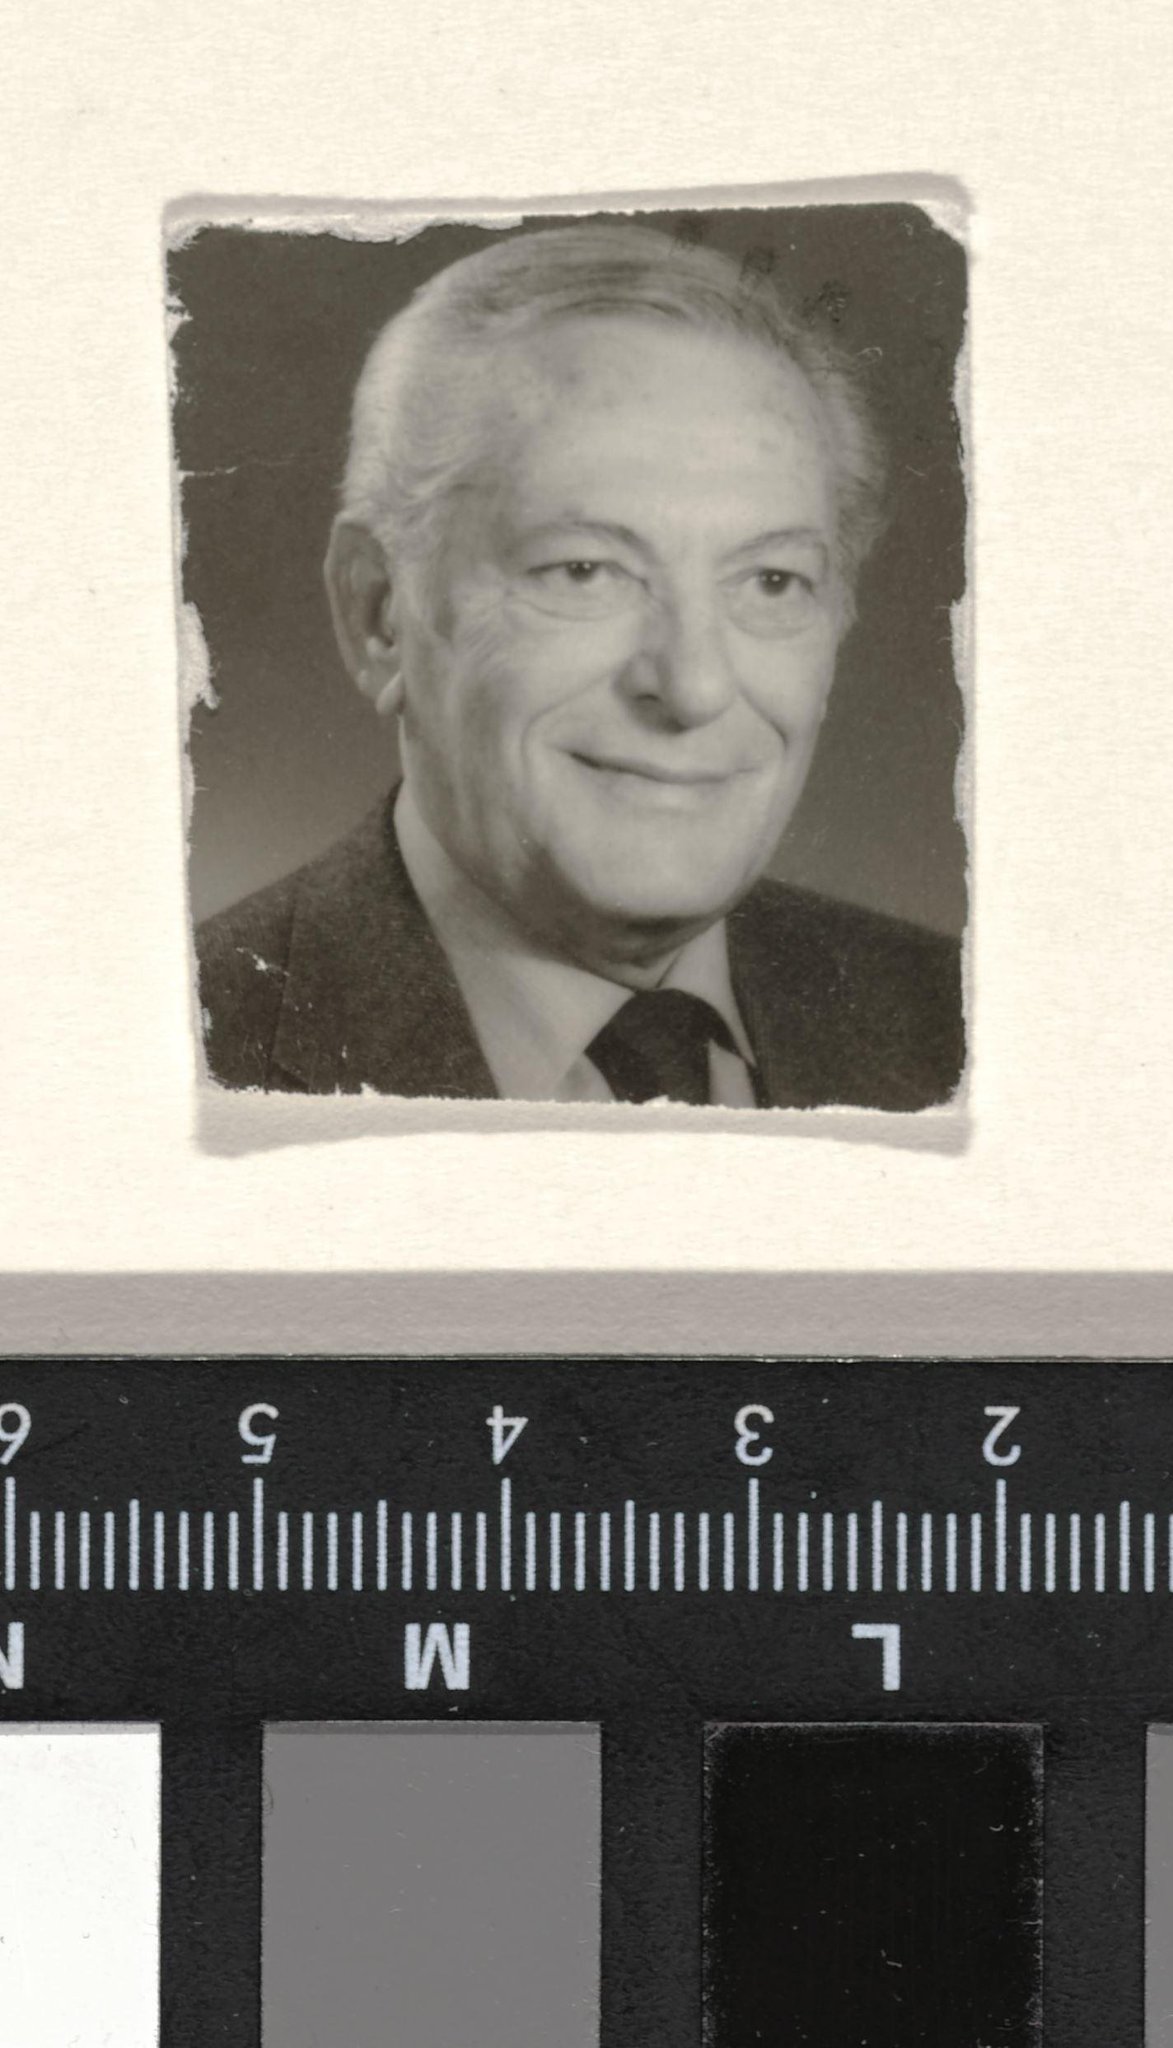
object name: photograph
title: Pasfoto van Gideon Elon, de derde echtgenoot van Isabel Wachenheimer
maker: Anonymous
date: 1956-2010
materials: photographic support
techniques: gelatin silver print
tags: gideon elon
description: Pasfoto van Gideon Elon, de derde echtgenoot van Isabel Wachenheimer.